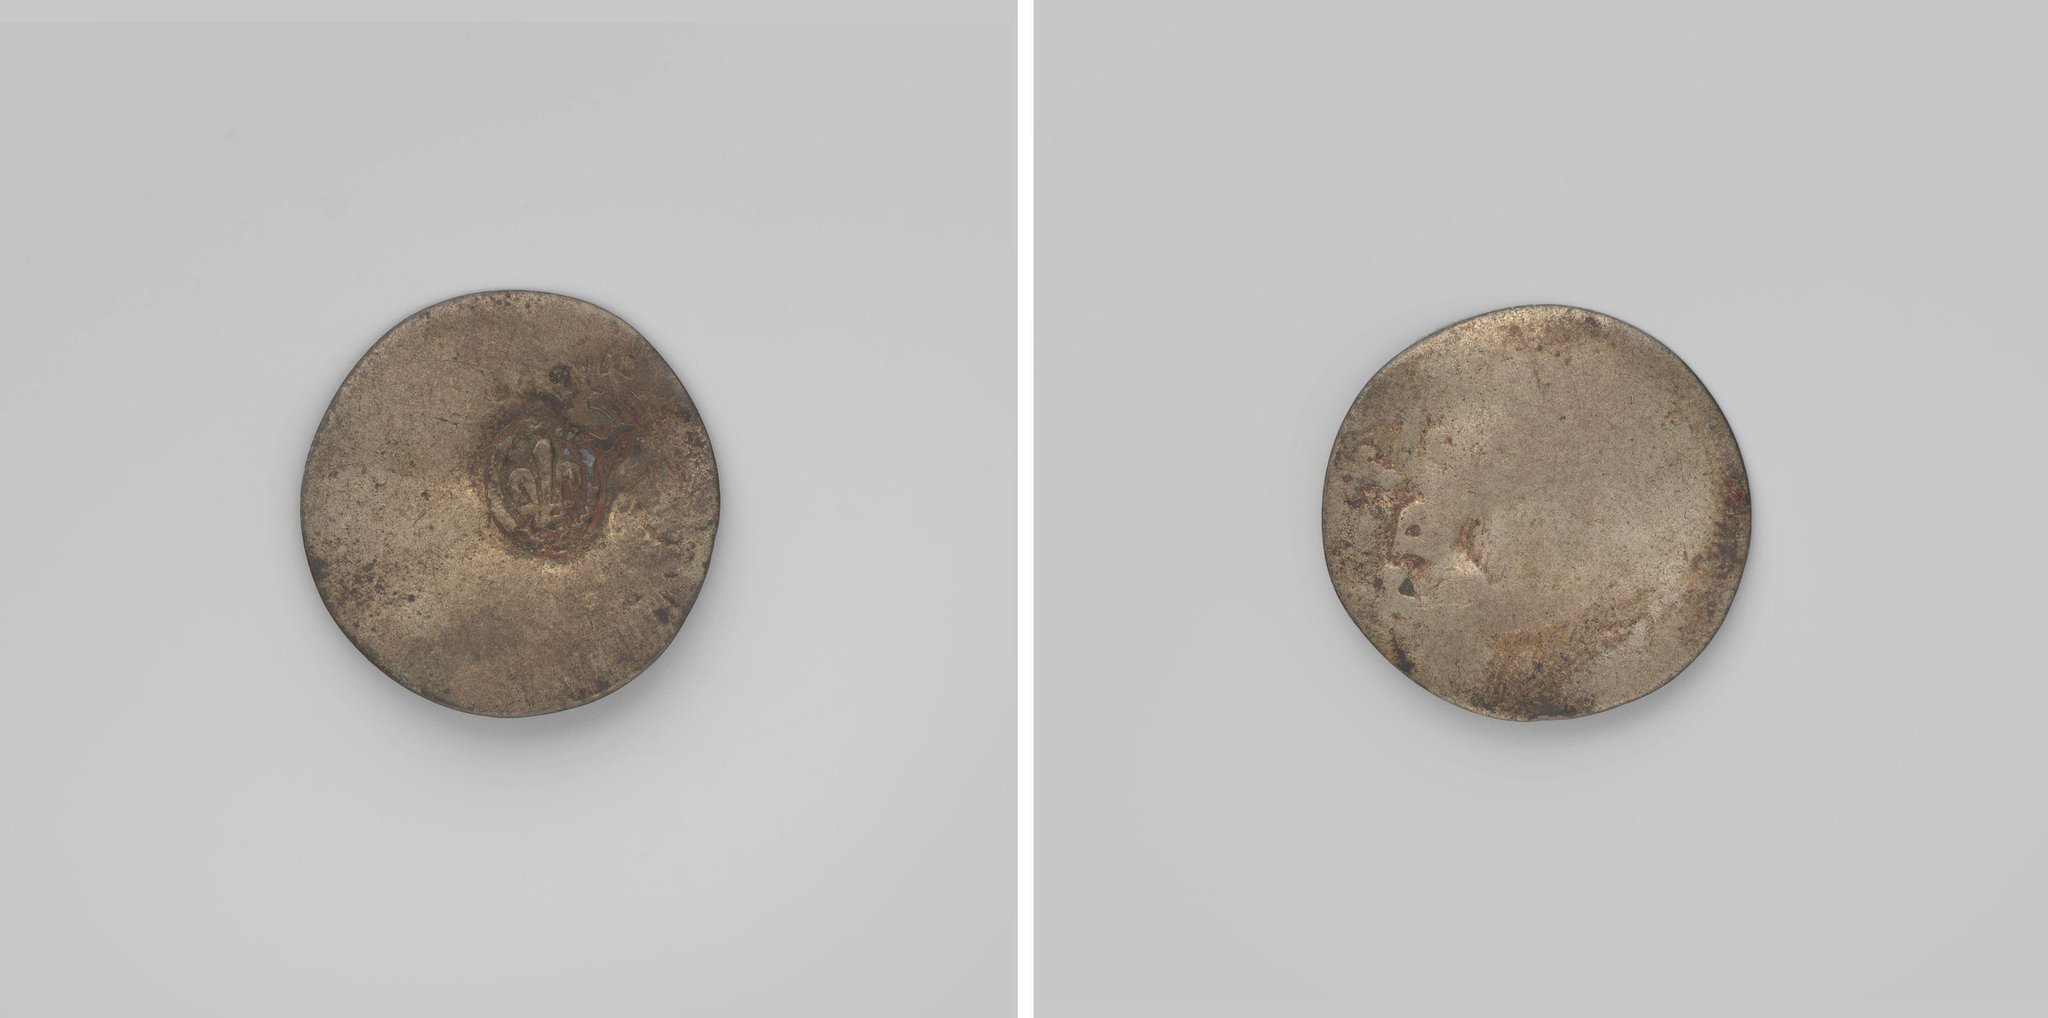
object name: coin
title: Pitji van Palembang, Sumatra, pitji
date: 1769-1821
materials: tin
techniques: casting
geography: palembang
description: Munt, voorzijde: zonder omschrift. Keerzijde, glad. In het midden rond gat.